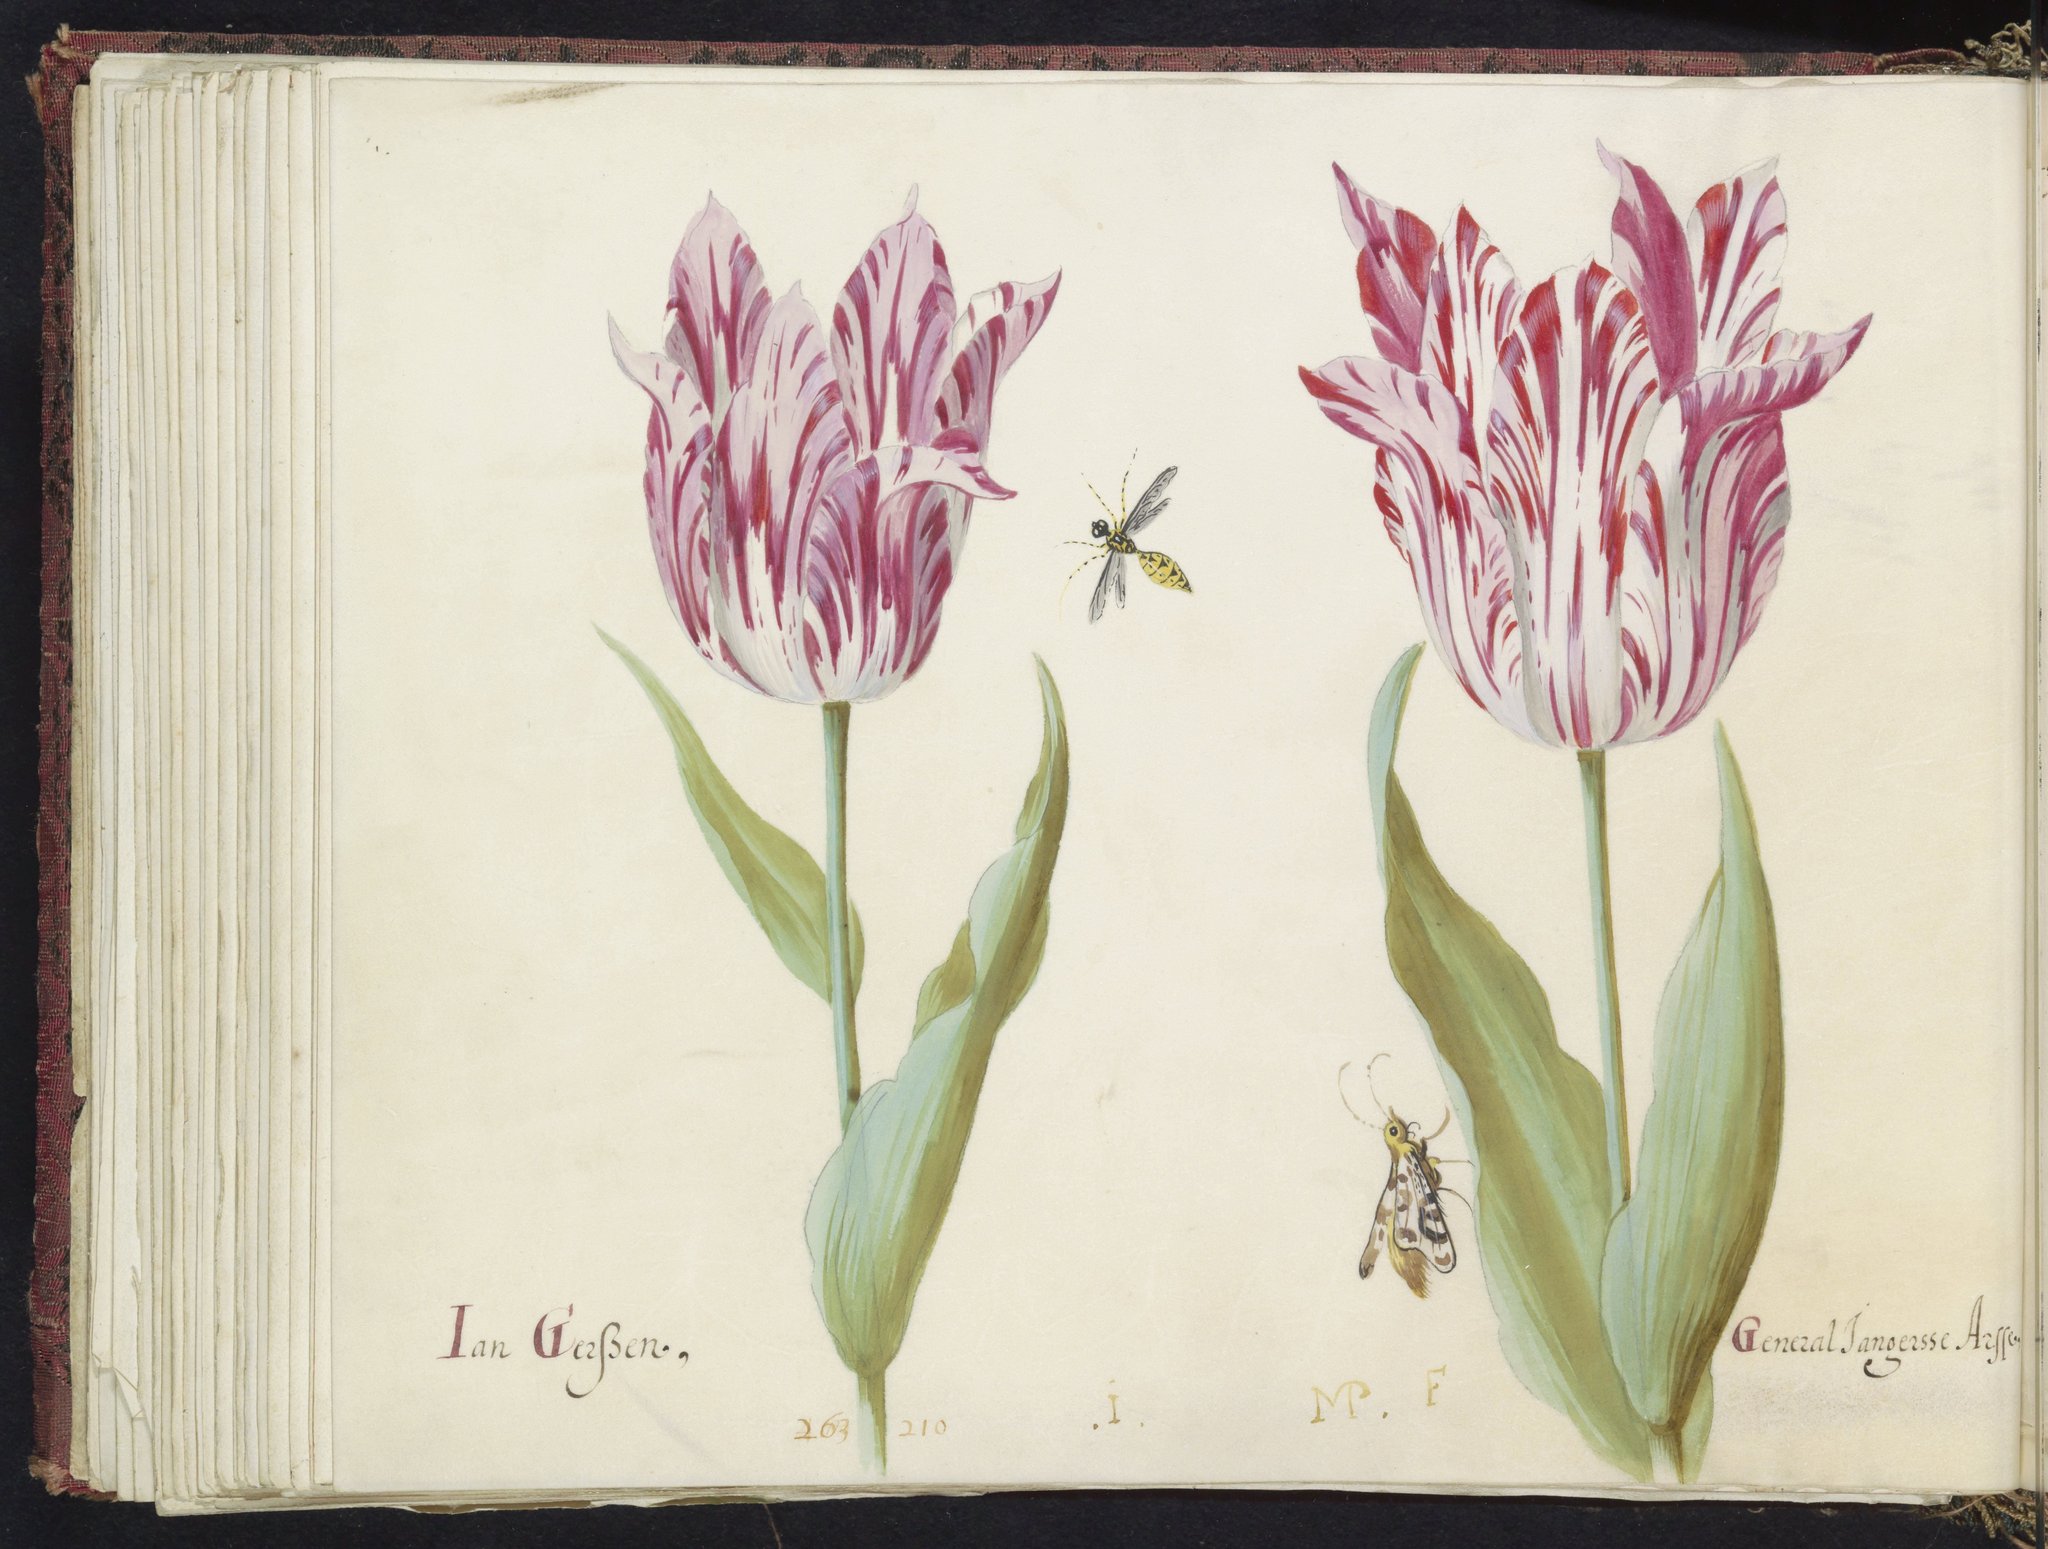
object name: album leaf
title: Twee tulpen met wesp en nachtvlinder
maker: jacob marrel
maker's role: draughtsman, painter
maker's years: 1614-1681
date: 1637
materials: paint, parchment, pencil, watercolor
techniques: brush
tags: insects: wasp, insects: butterfly, flowers: tulip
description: De tekening maakt deel uit van een album.